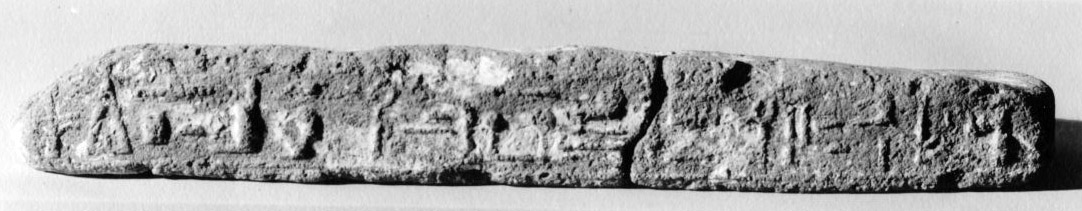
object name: brick, userhat, brick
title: Stamped Brick of Userhat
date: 1550-1295 BCE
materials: pottery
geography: egypt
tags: hieroglyphs